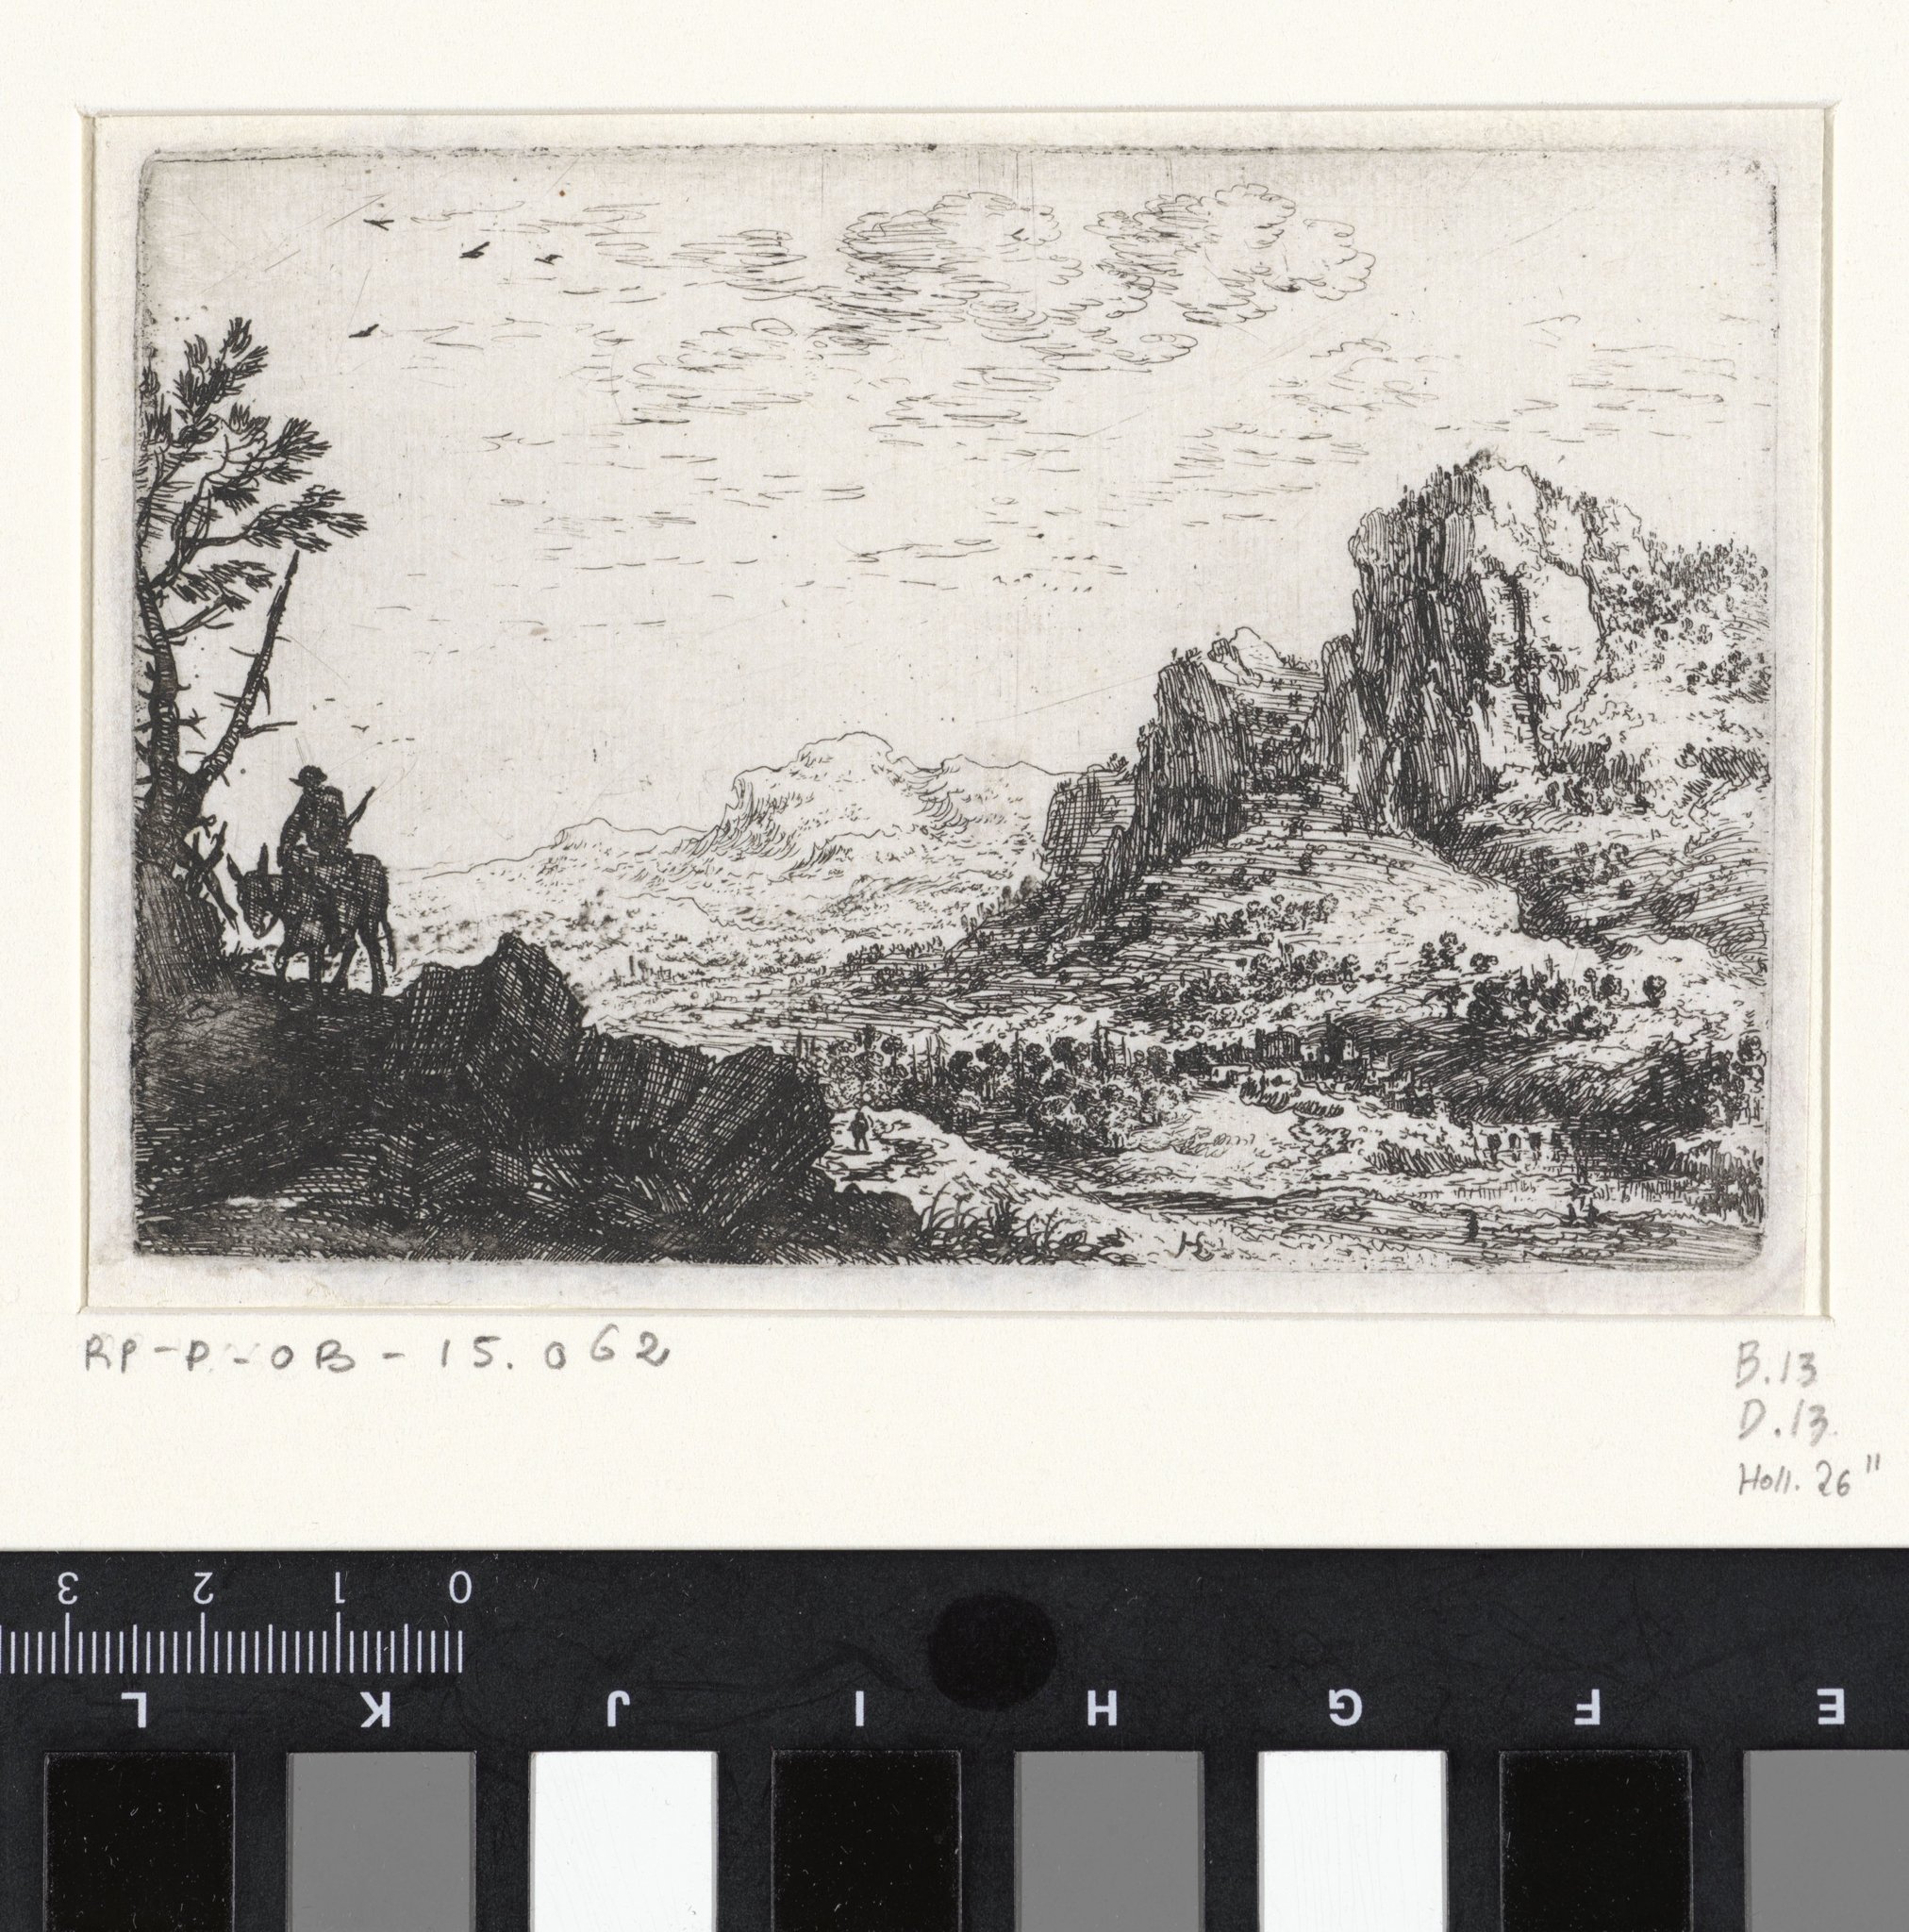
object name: print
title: Rotsachtige landschappen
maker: herman saftleven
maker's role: draughtsman, painter, print maker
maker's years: 1609-1685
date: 1626-1685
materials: paper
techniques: etching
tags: ass, donkey, rock-formations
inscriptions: collector's mark: Lugt 240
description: Gezicht op een bergachtig landschap, met op de voorgrond een man op een ezel.